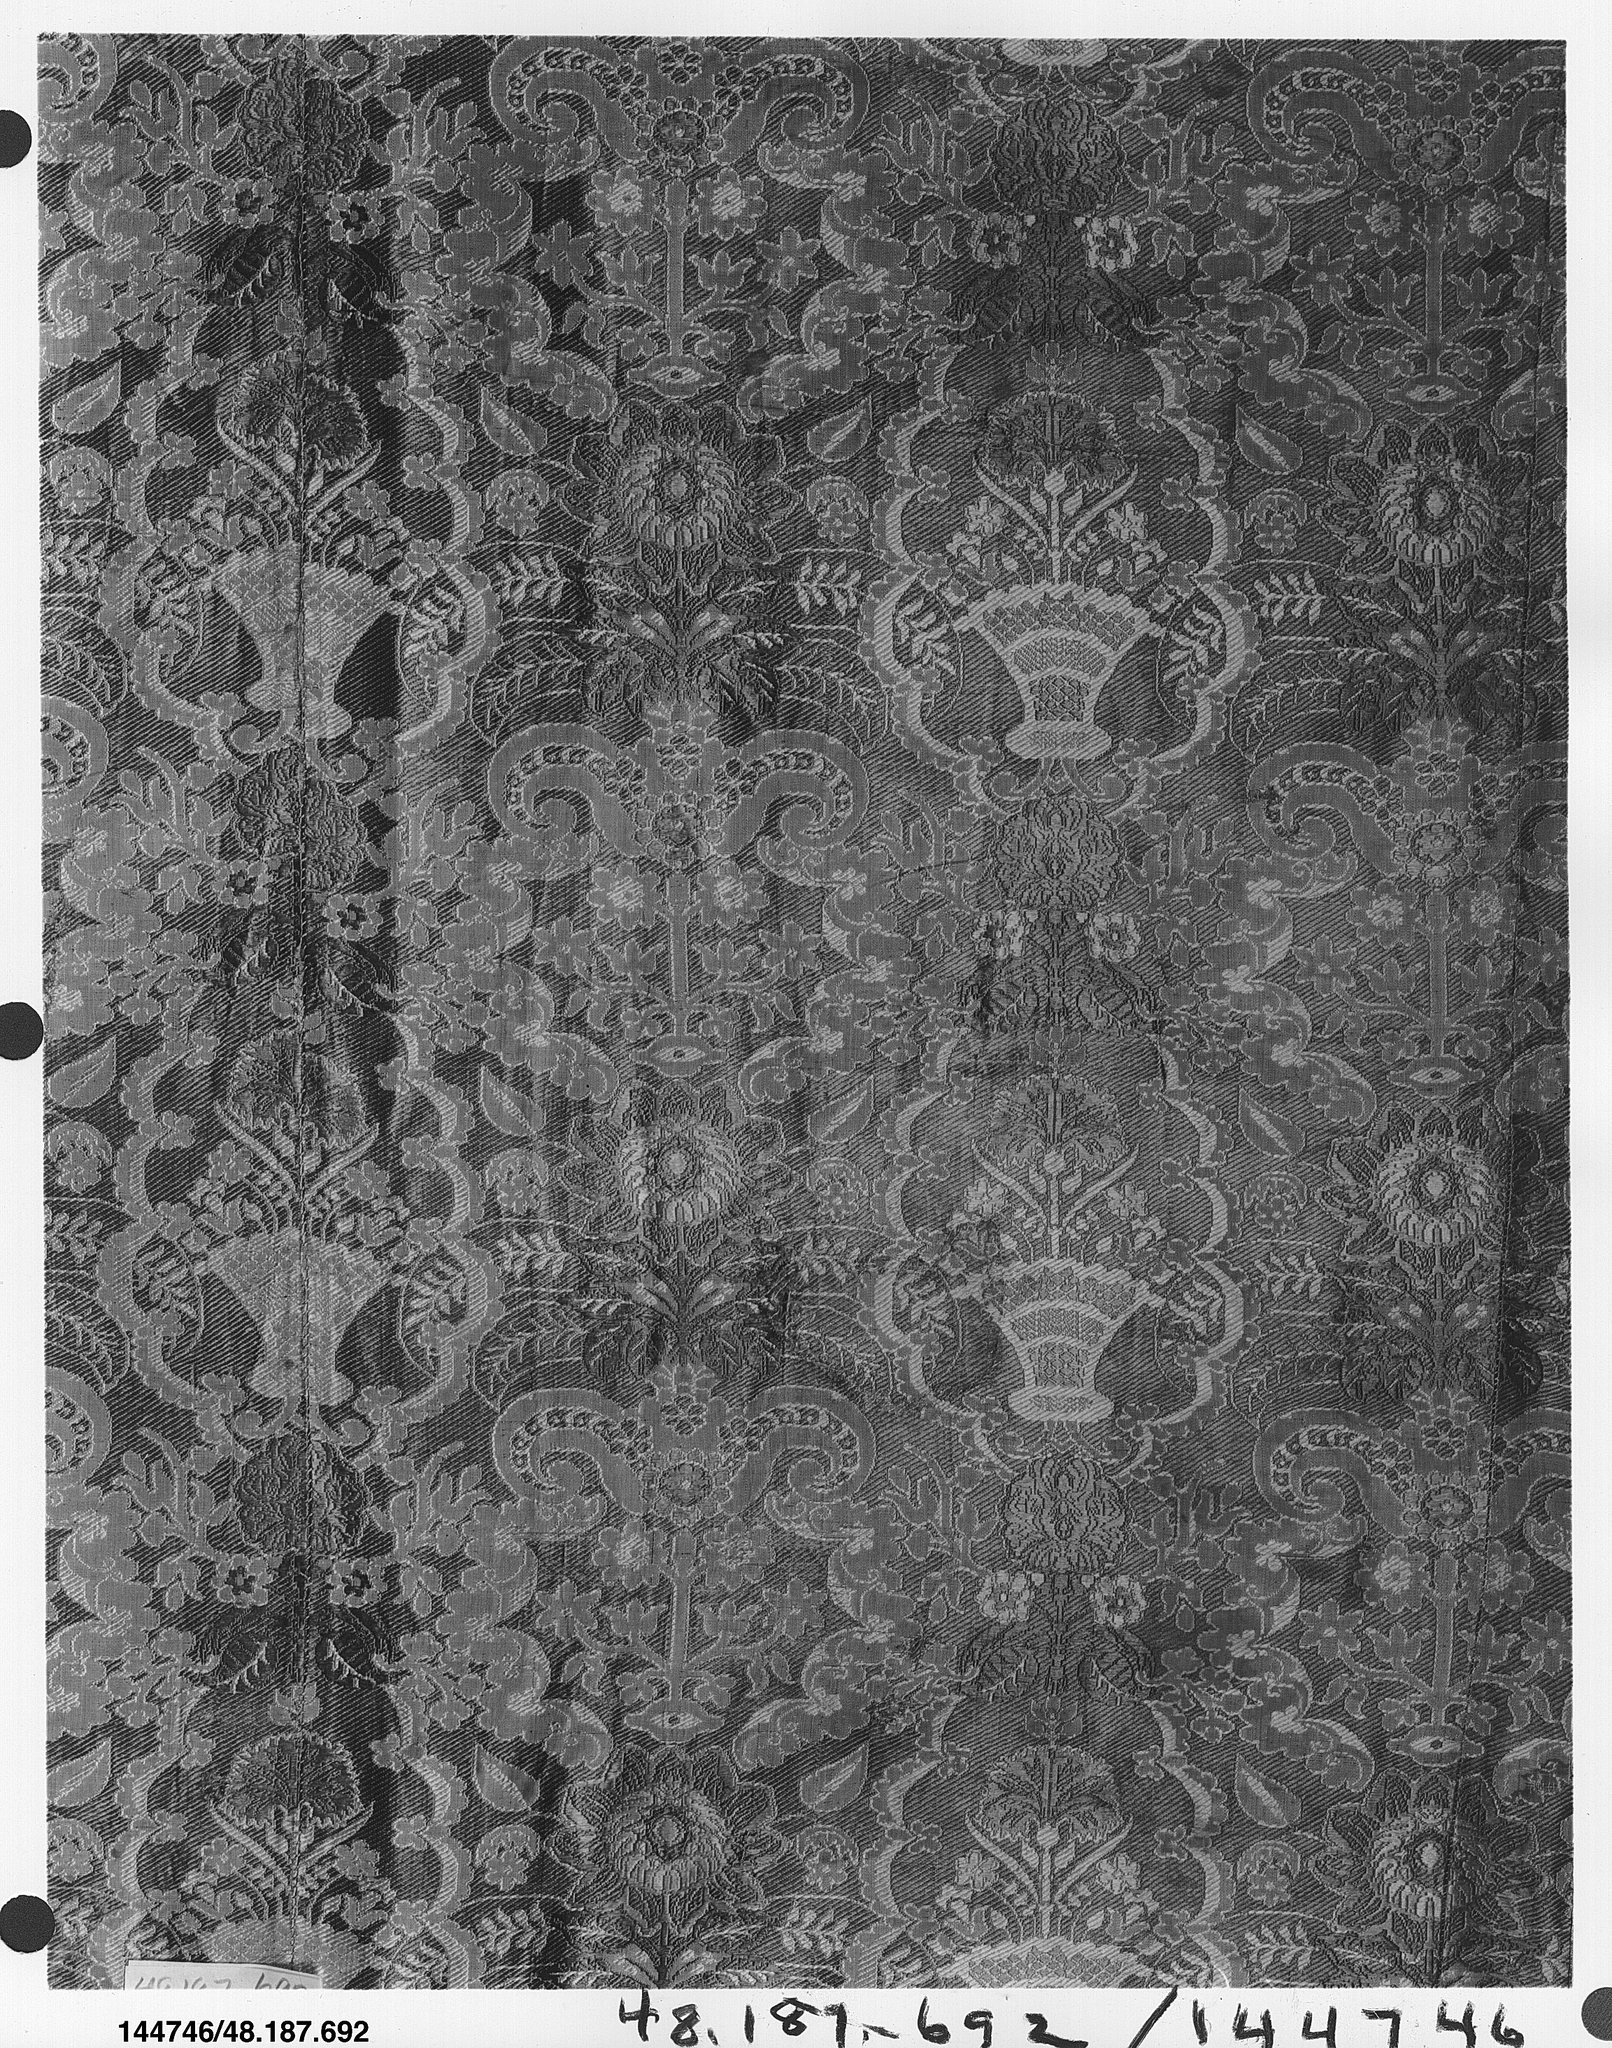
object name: piece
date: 1725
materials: silk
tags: flowers